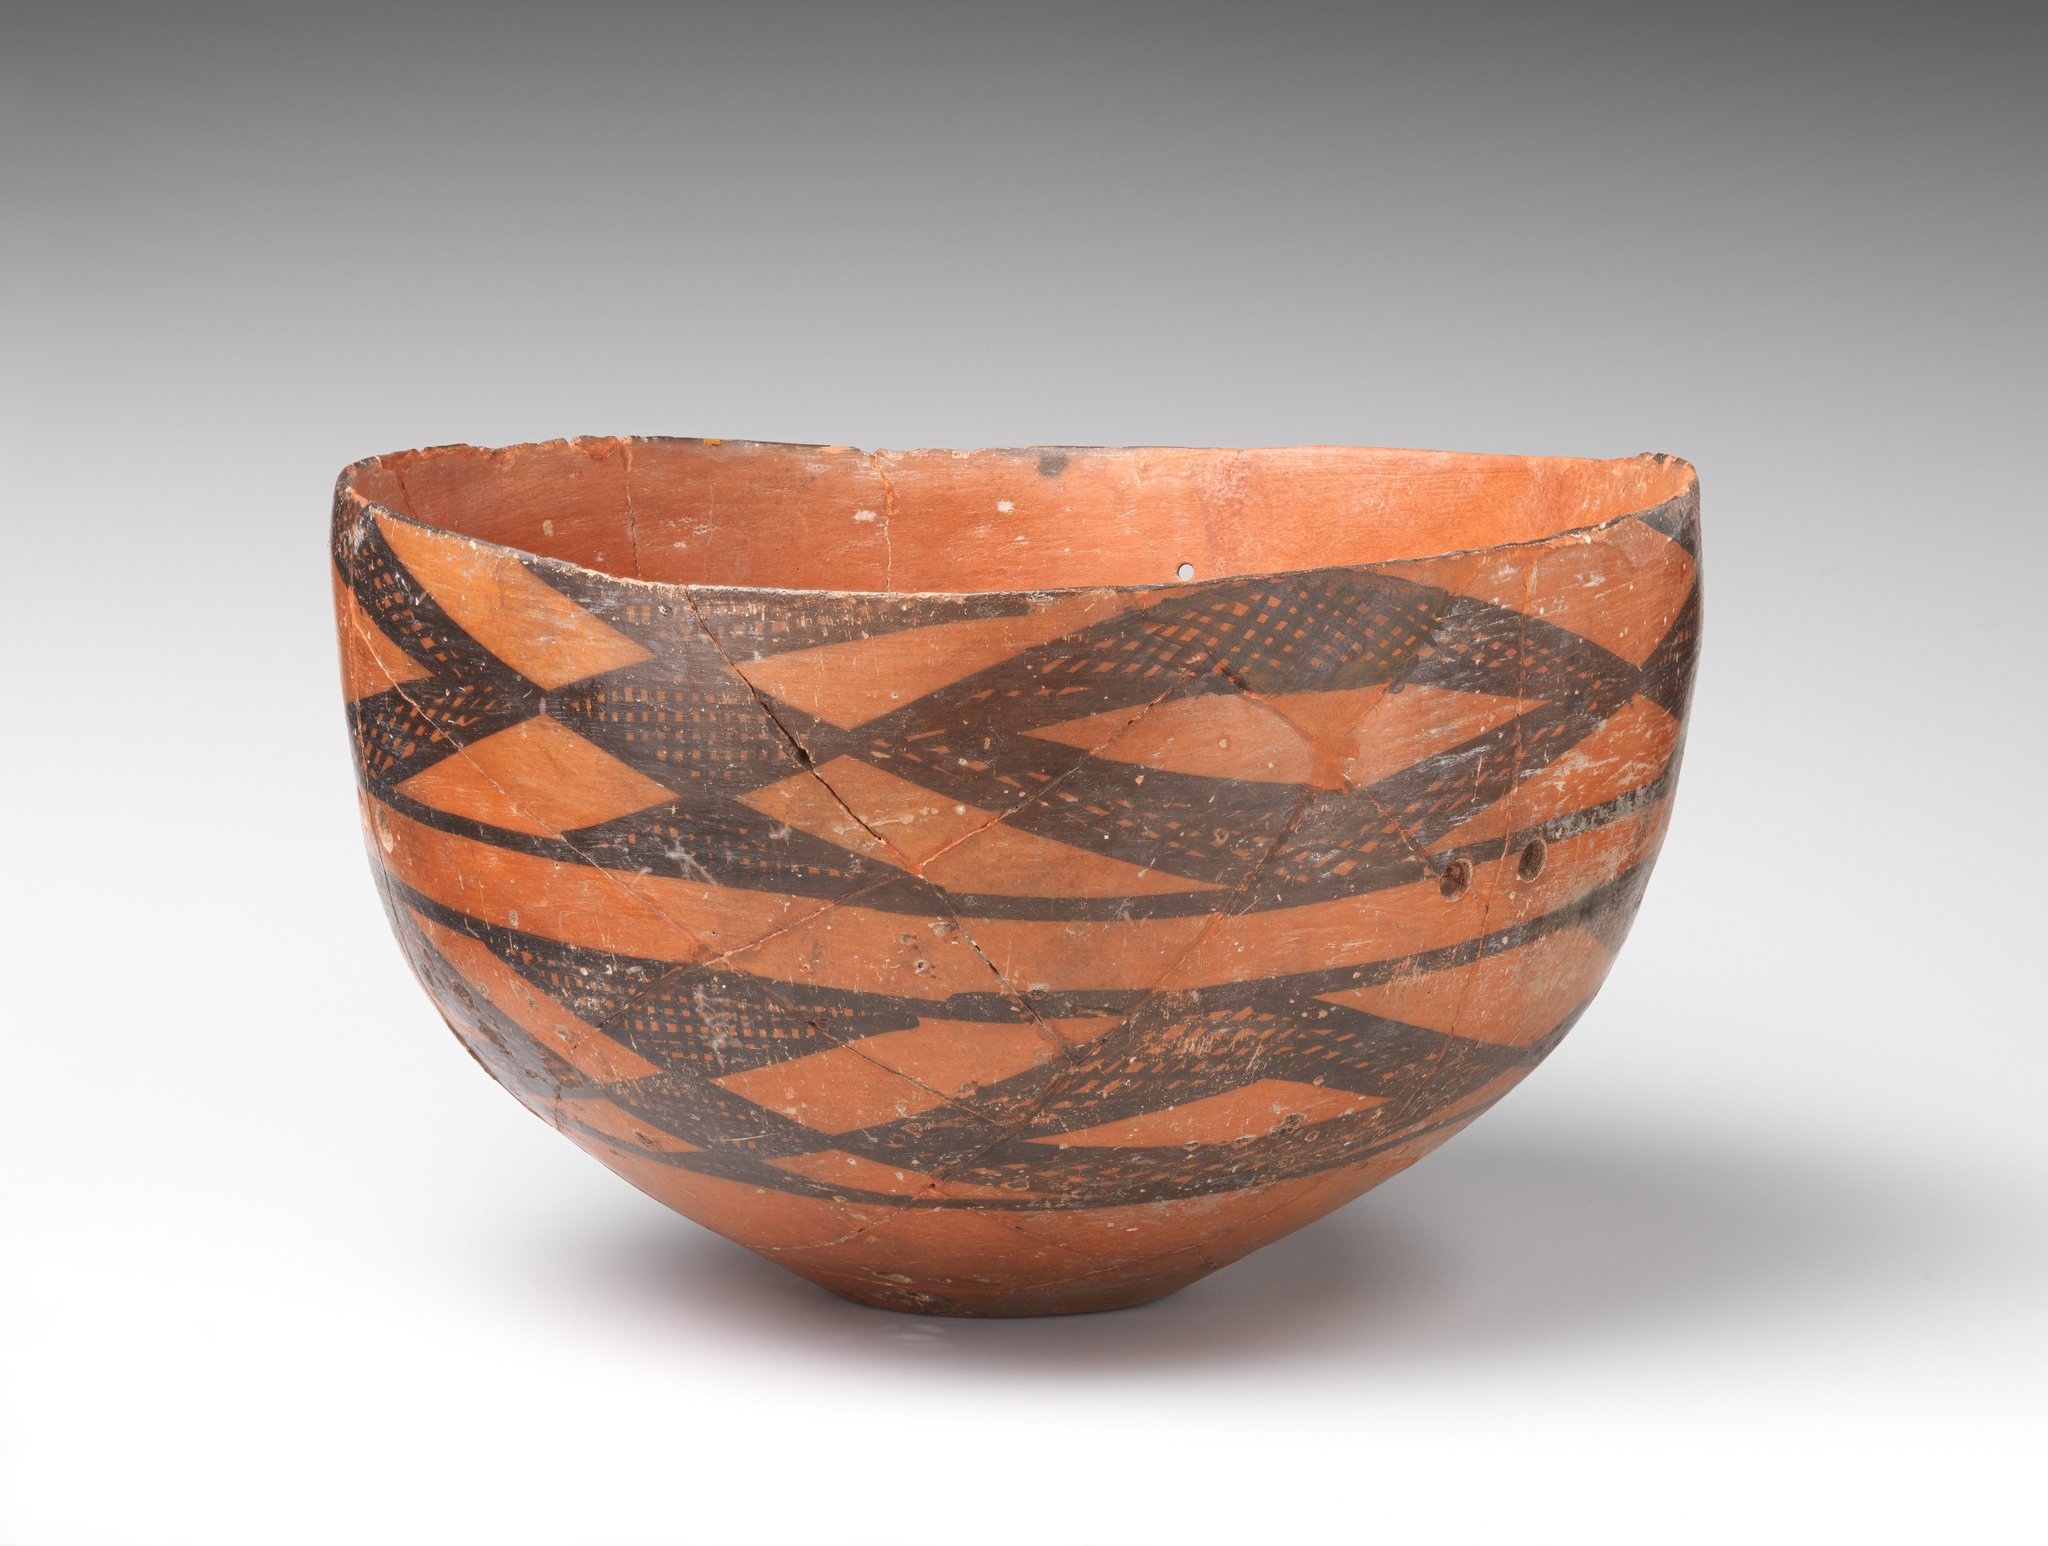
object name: bowl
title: Bowl with cross-hatched decoration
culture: iranian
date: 5300-4300 BCE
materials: ceramic, paint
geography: iran